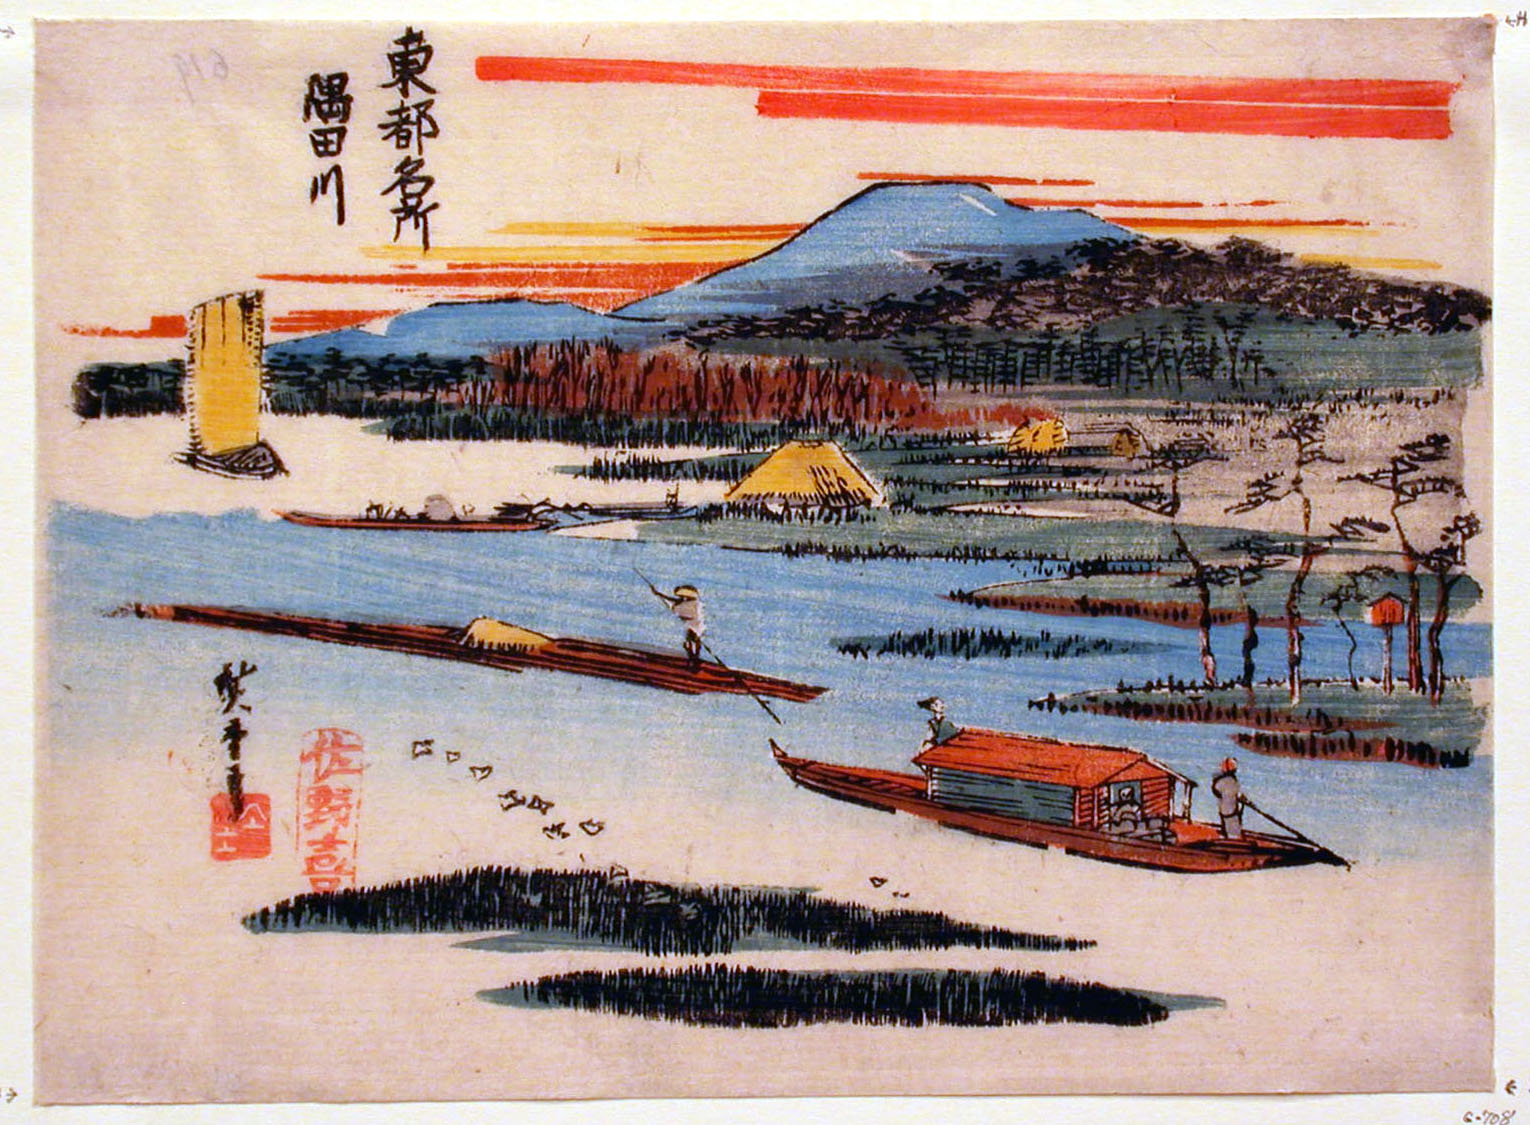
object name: print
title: Boat on the Sumida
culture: japanese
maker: utagawa hiroshige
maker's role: artist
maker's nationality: japanese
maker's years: 1797-1858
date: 1817-1858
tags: landscapes,boats